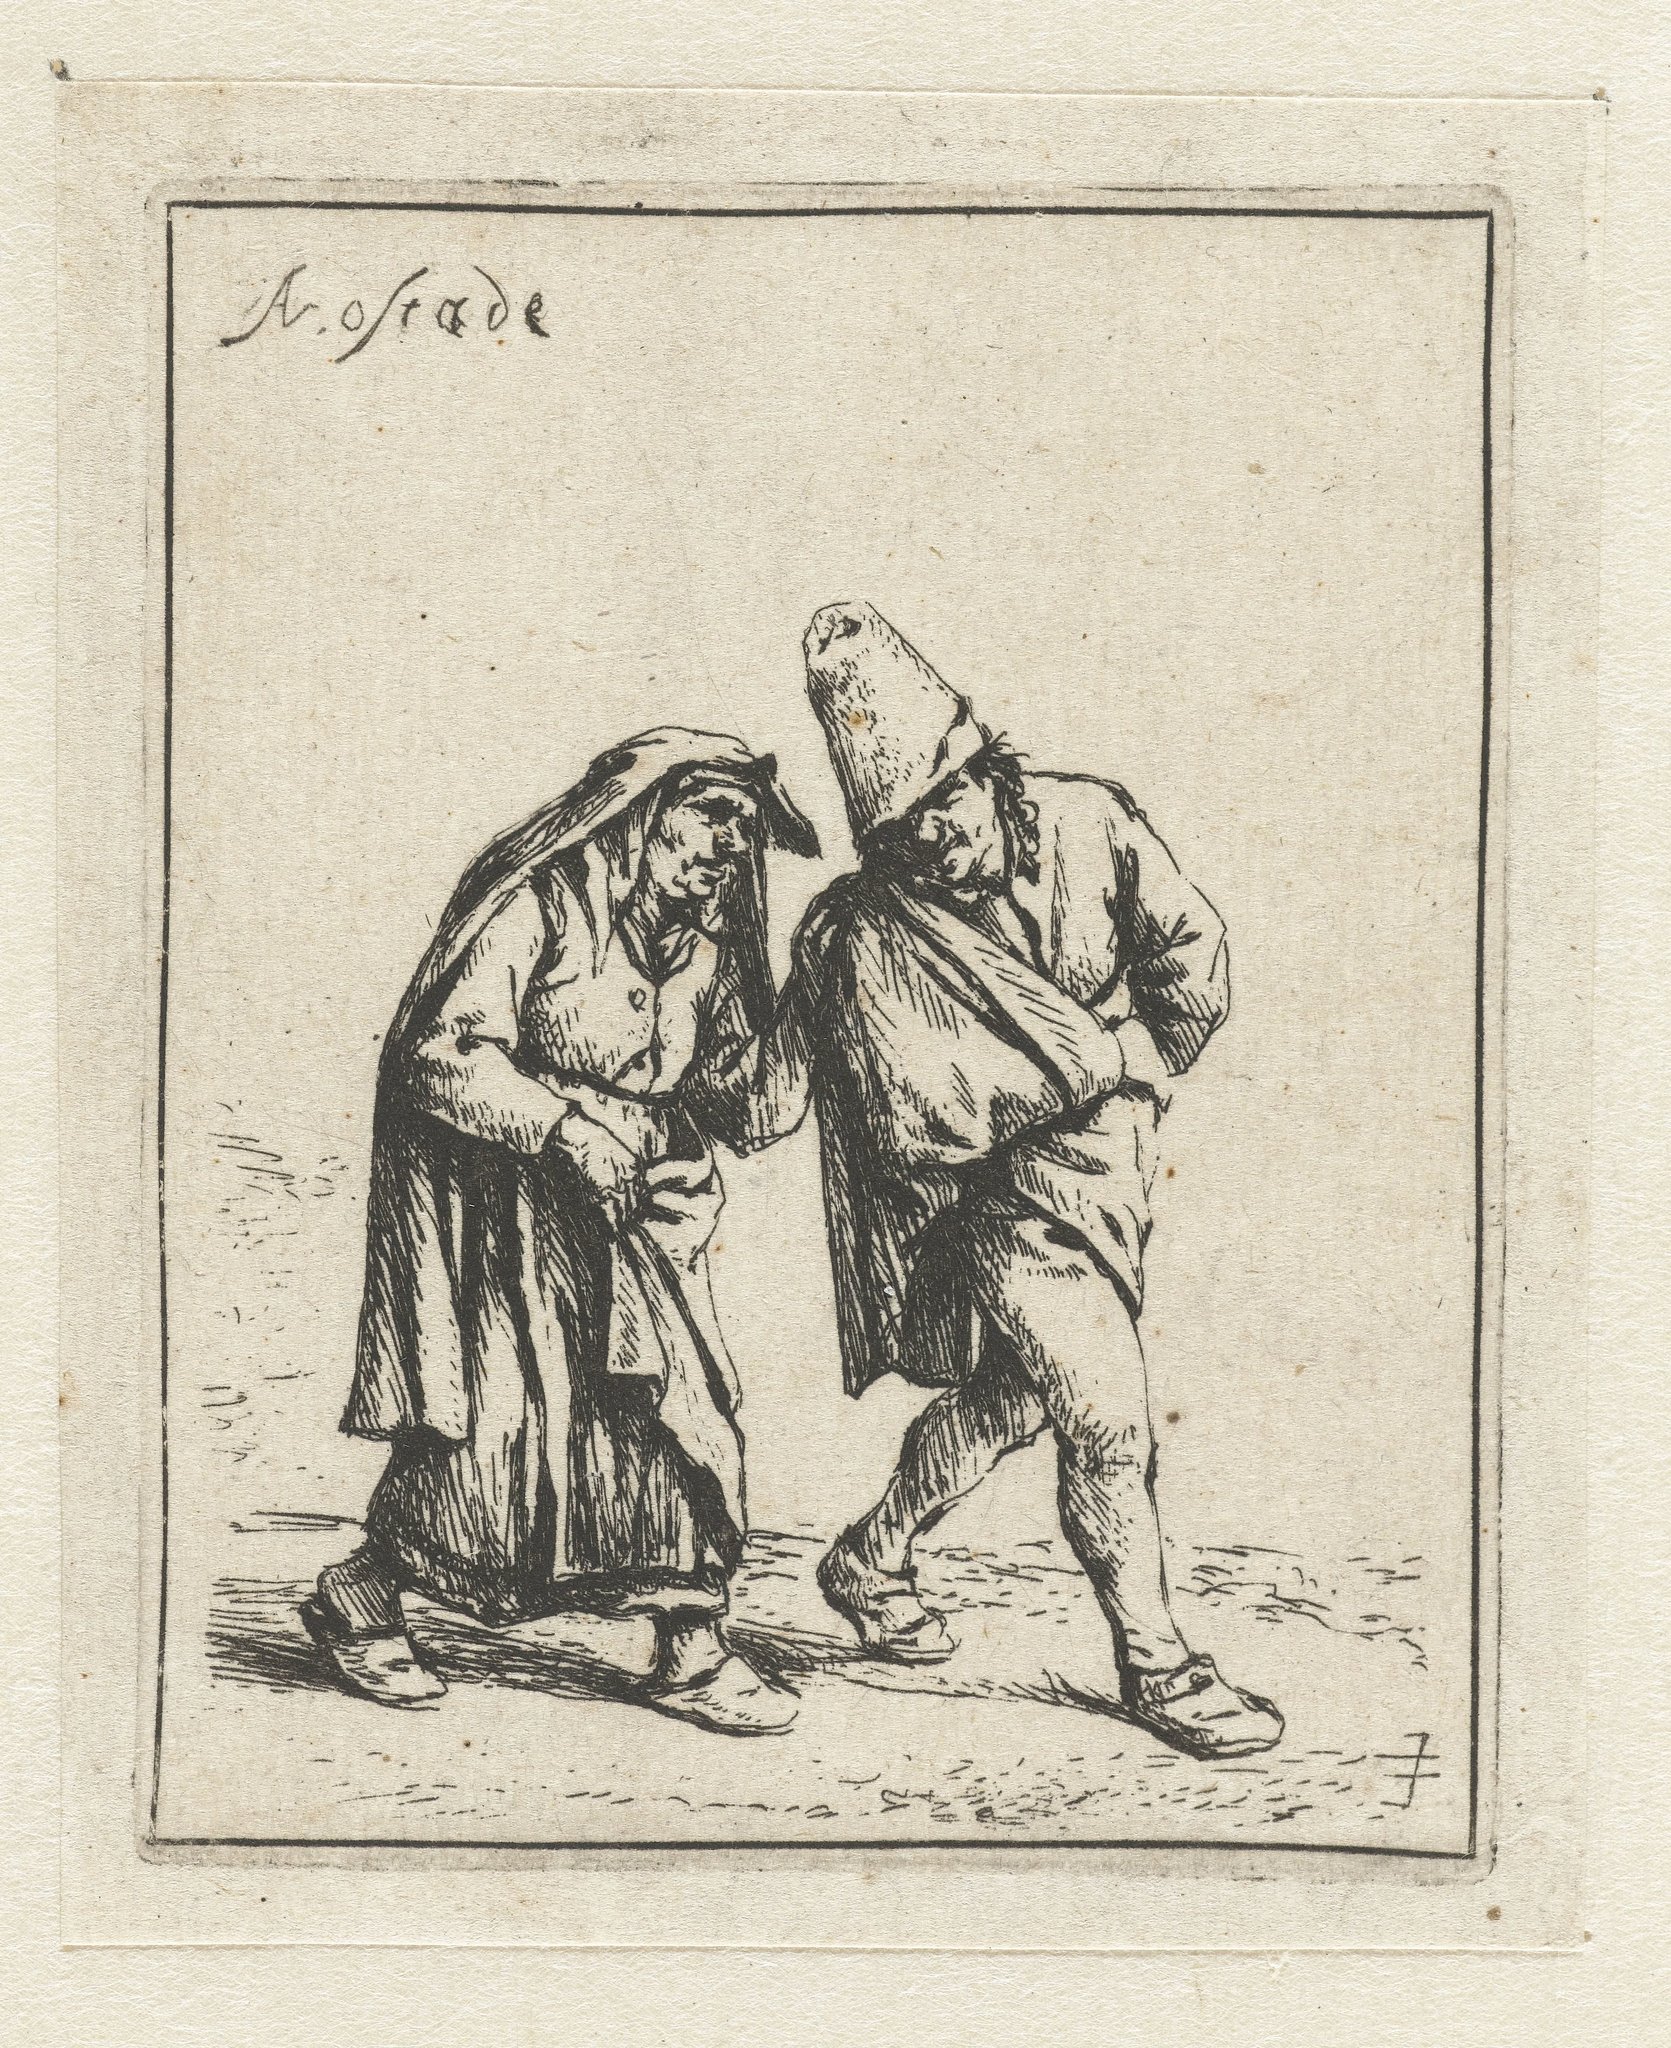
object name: print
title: Wandelend boerenpaar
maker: adriaen van ostade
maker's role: draughtsman, painter, print maker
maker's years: 1610-1685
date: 1646-1649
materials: paper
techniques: etching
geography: haarlem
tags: farmers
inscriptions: collector's mark: Lugt 240